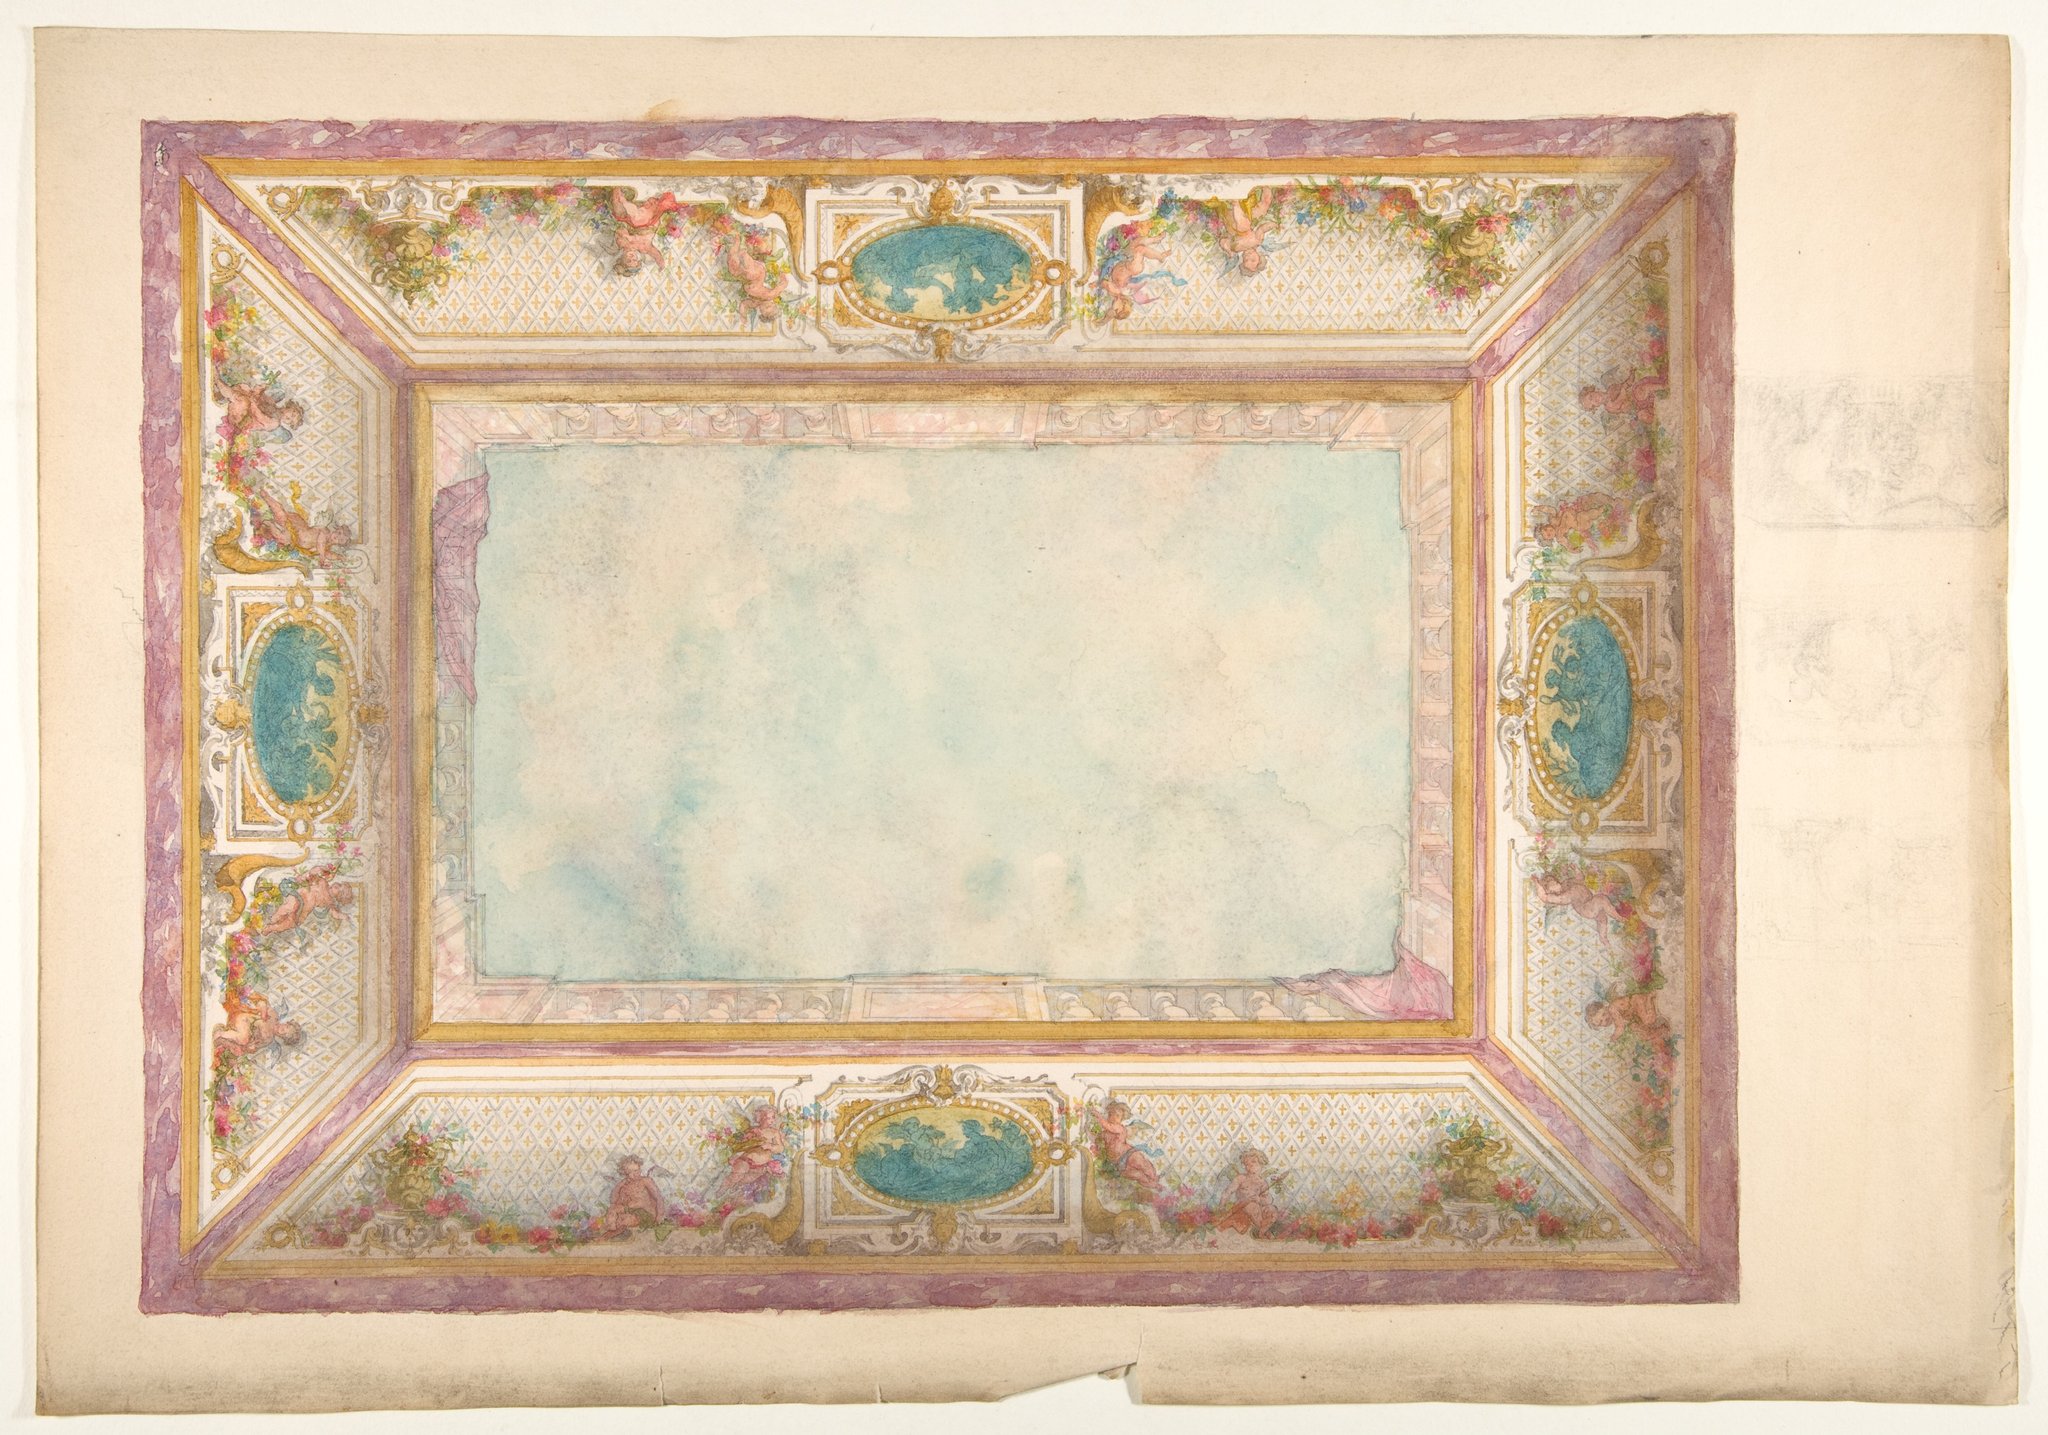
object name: drawing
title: Design for a ceiling with trompe l'oeil balustrade and putti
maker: jules-edmond-charles lachaise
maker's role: artist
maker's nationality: french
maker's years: 1897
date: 1851-1900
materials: graphite, watercolor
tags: ceilings